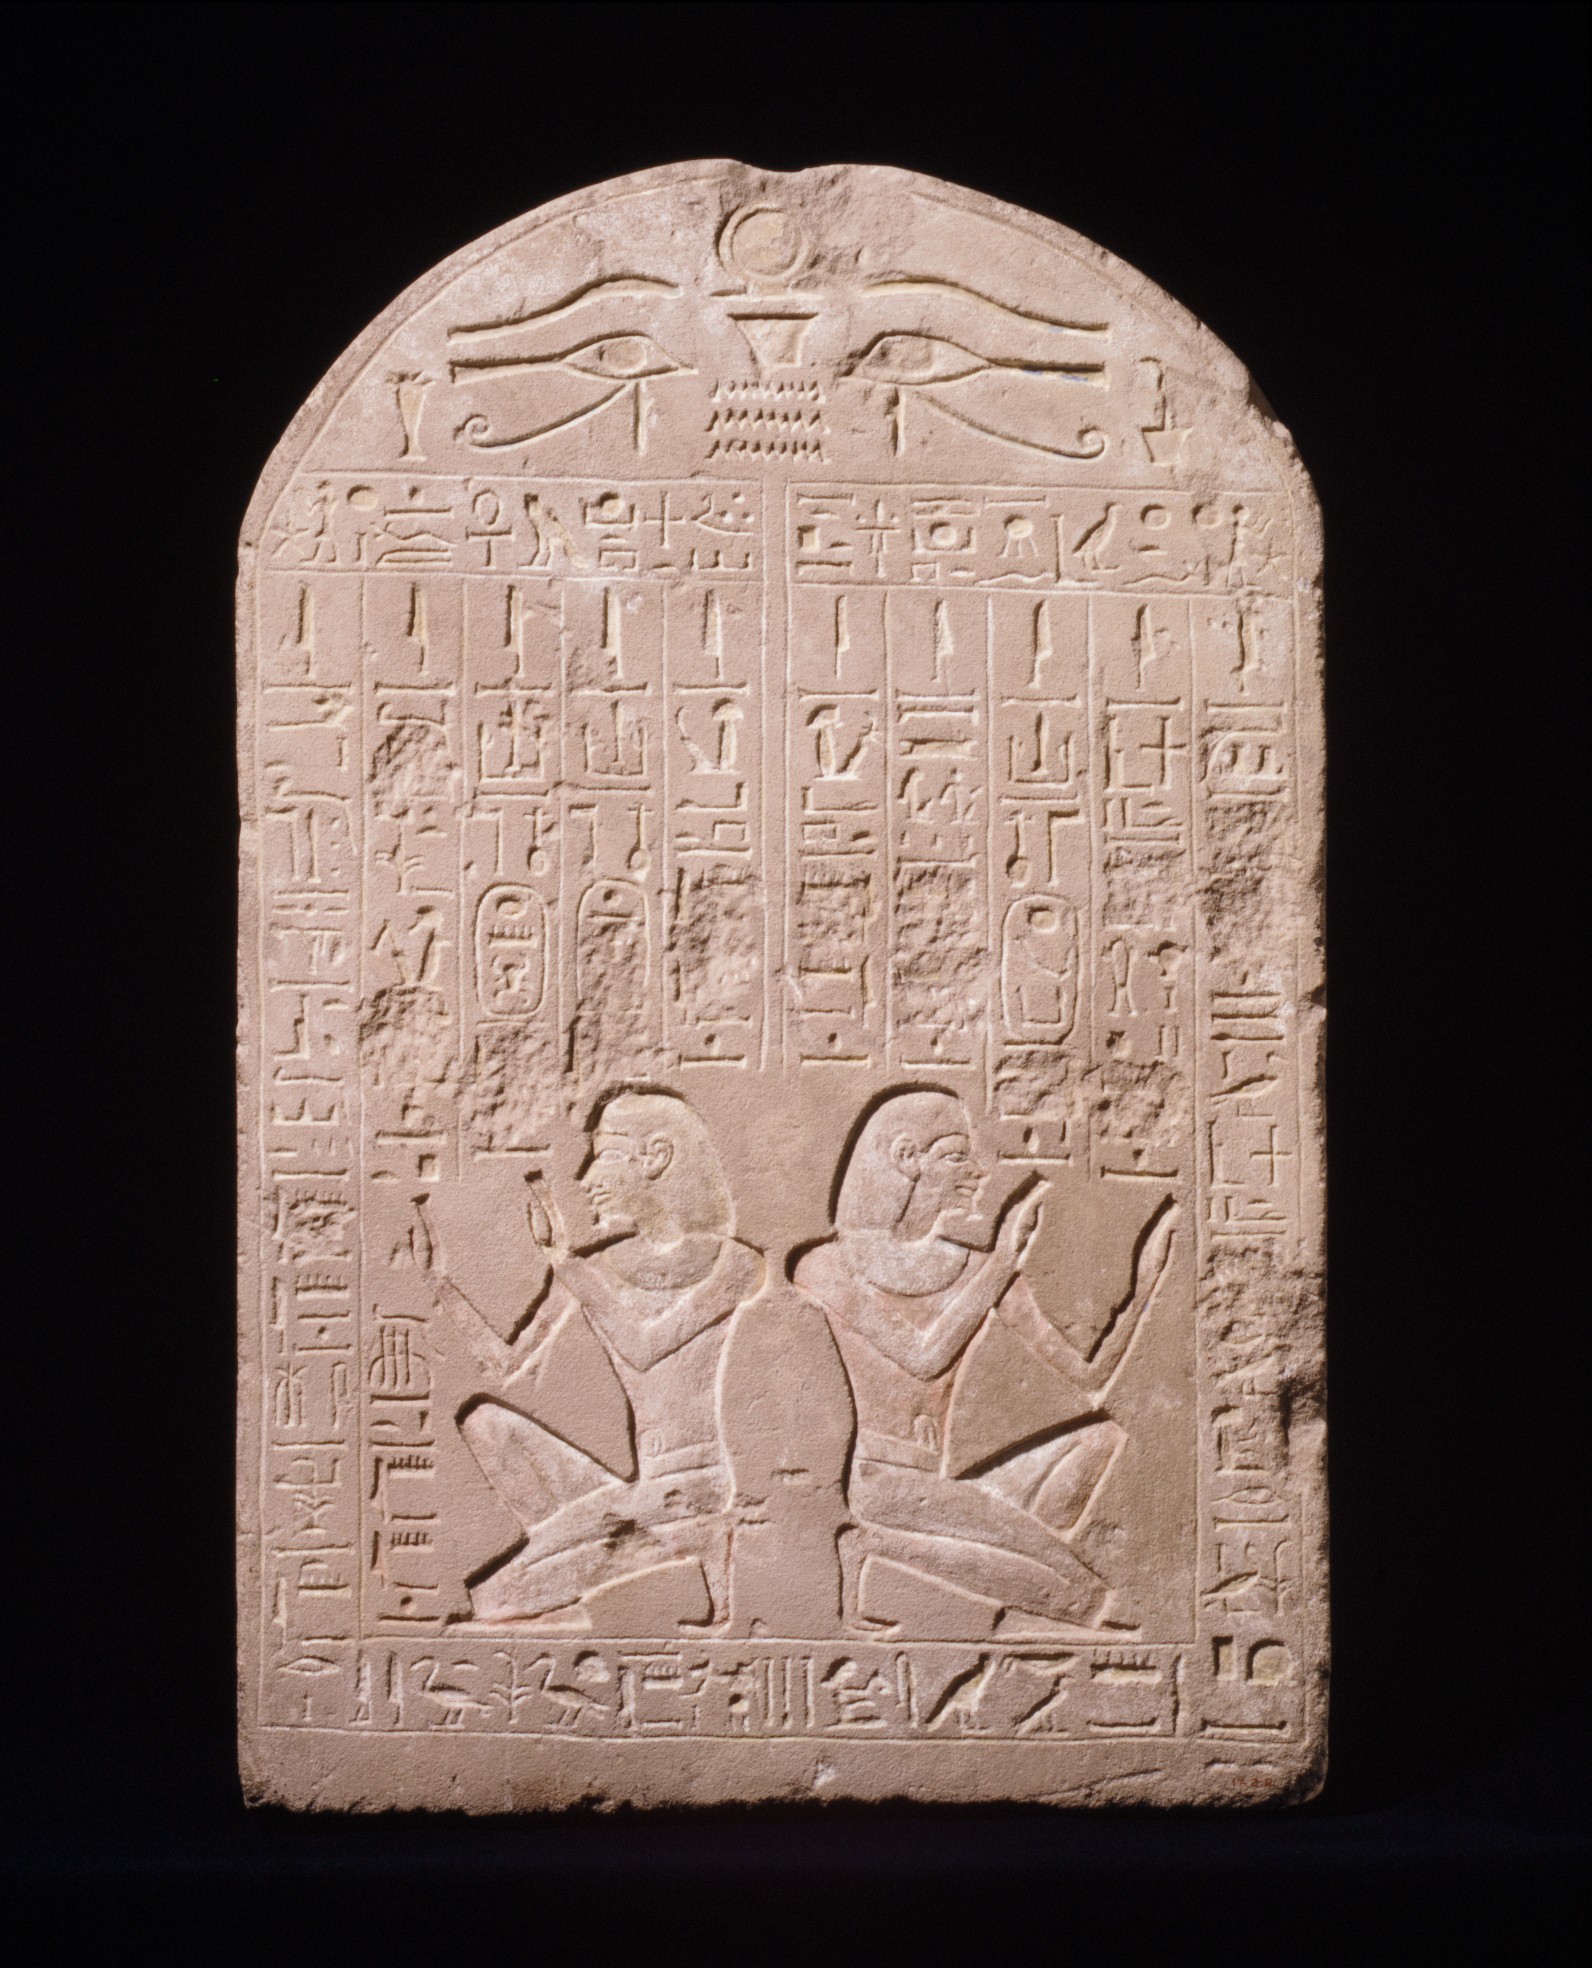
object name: stela, amenhotep, rising and setting sun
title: Stela of Amenhotep Adoring the Rising and Setting Sun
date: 1427-1400 BCE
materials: paint, stone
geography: egypt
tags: human figures,hieroglyphs